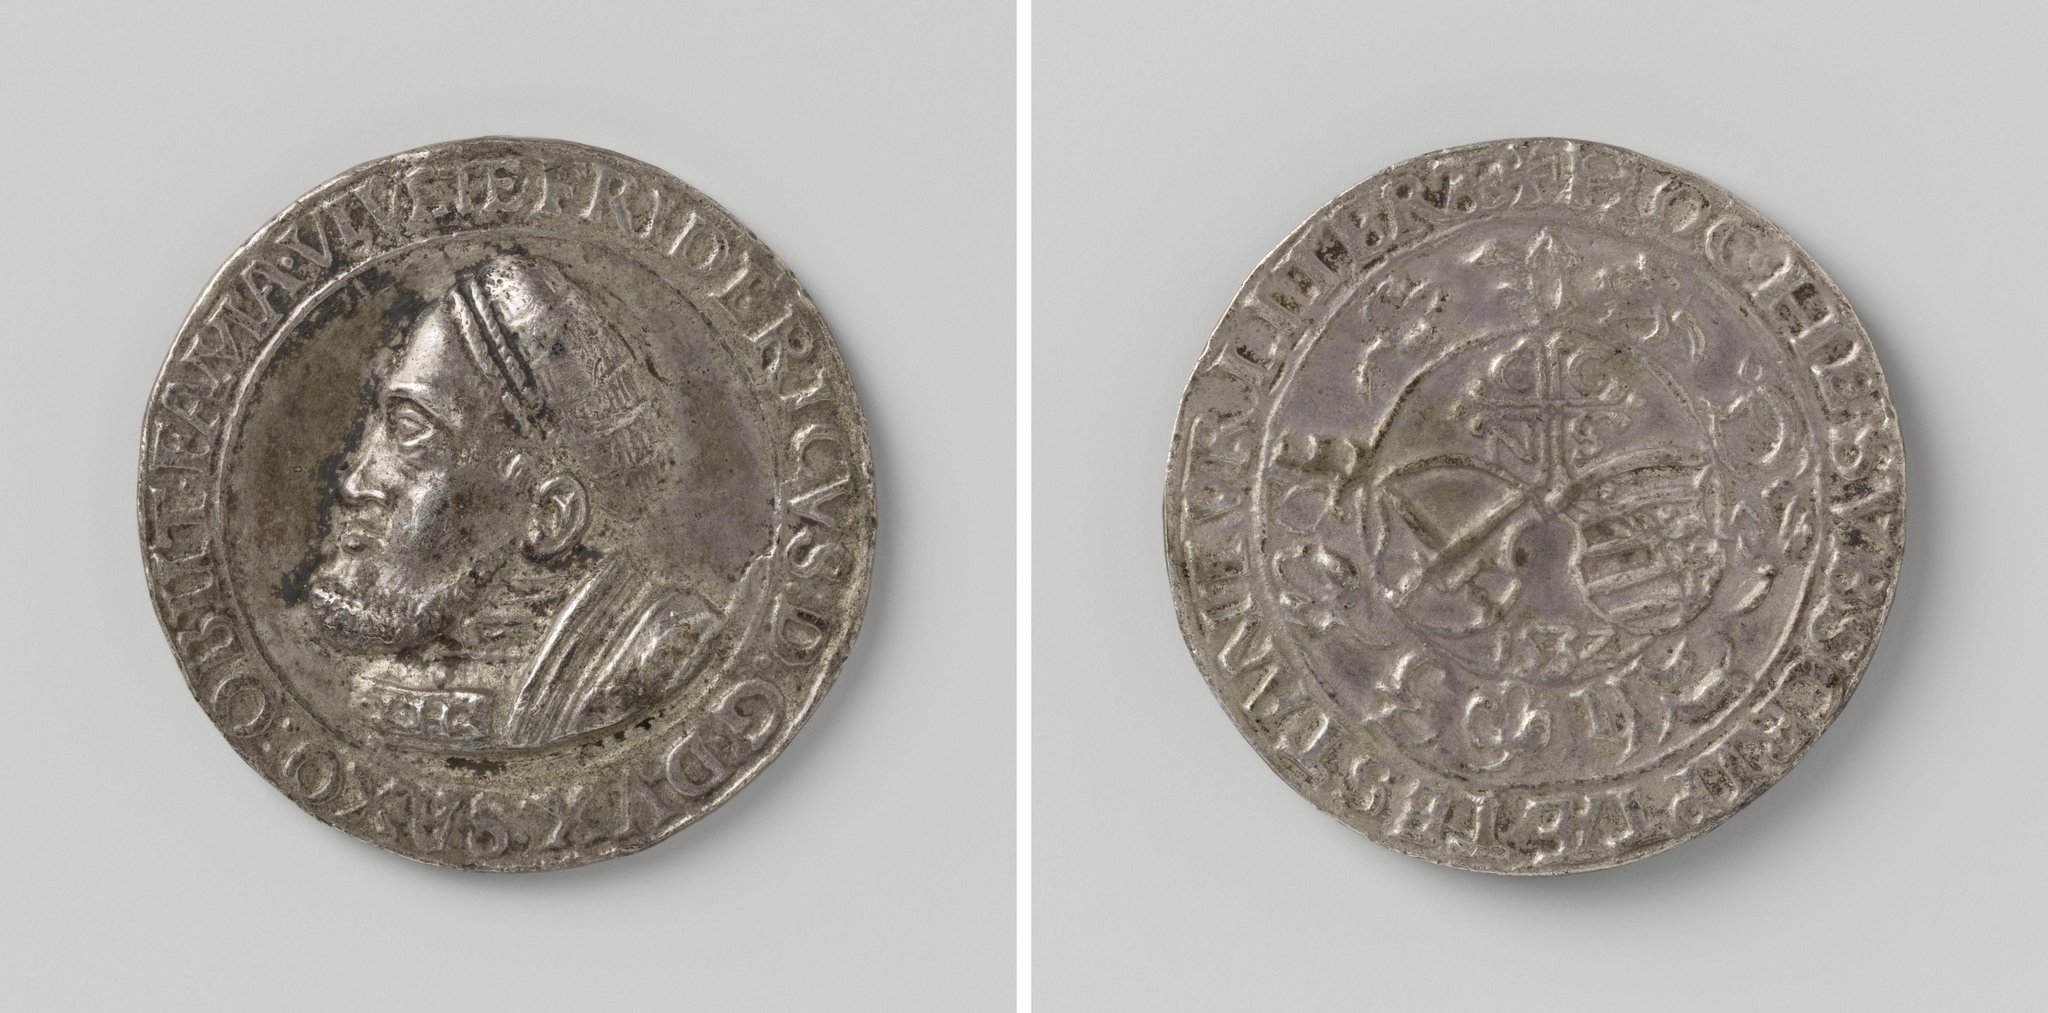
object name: history medal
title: Ter ere van de overleden Frederik III de Wijze, keurvorst van Saksen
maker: Anonymous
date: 1532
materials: silver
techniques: striking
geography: germany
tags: torgau, lochau, keurvorst van saksen frederik iii de wijze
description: Zilveren penning. Voorzijde: borststuk man binnen omschrift. Keerzijde: wapenschild boven jaartal binnen rand van sierletters en omschrift